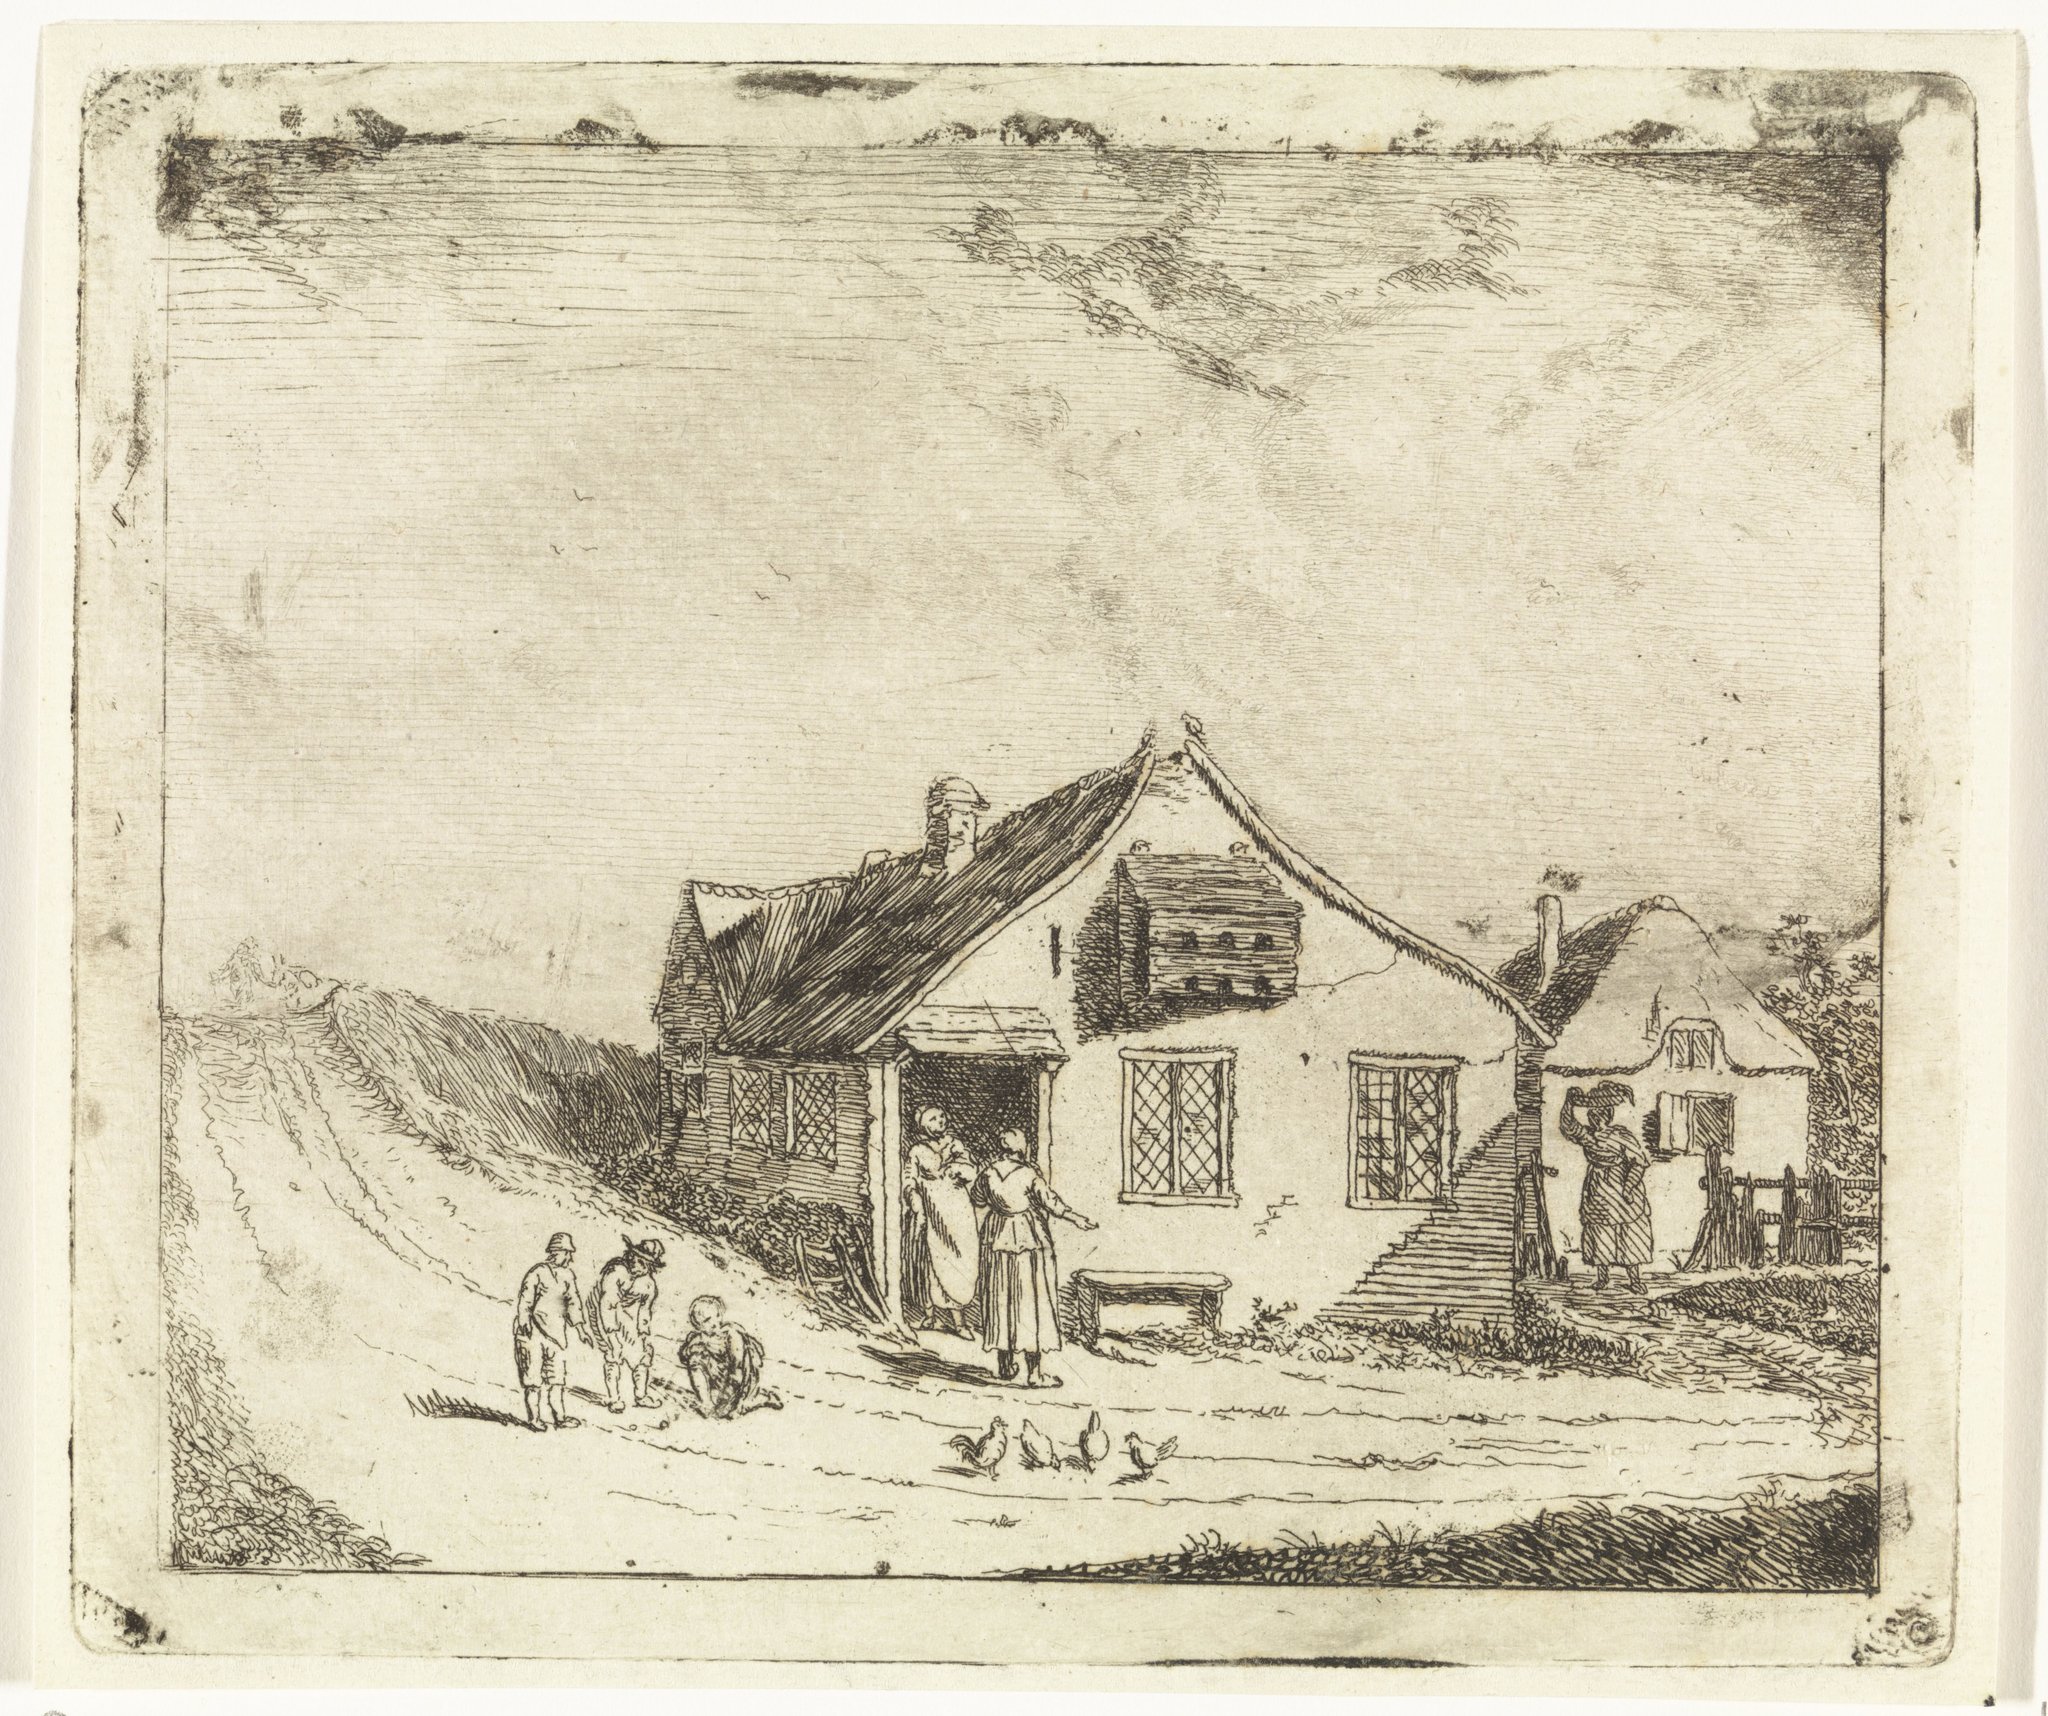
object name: print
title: Twee huizen aan een weg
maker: johannes huibert prins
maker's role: draughtsman, painter, print maker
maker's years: 1757-1806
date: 1767-1806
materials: paper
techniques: etching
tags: dove-cote, cottage, (playing at) marbles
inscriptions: collector's mark: Lugt 240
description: Voor twee rietgedekte huizen langs een weg staan een paar vrouwen te praten. Een andere vrouw draagt een mand op haar hoofd. Op de weg scharrelen kippen en spelen drie kinderen met knikkers. Aan de gevel van het grootste huis hangt een duiventil.